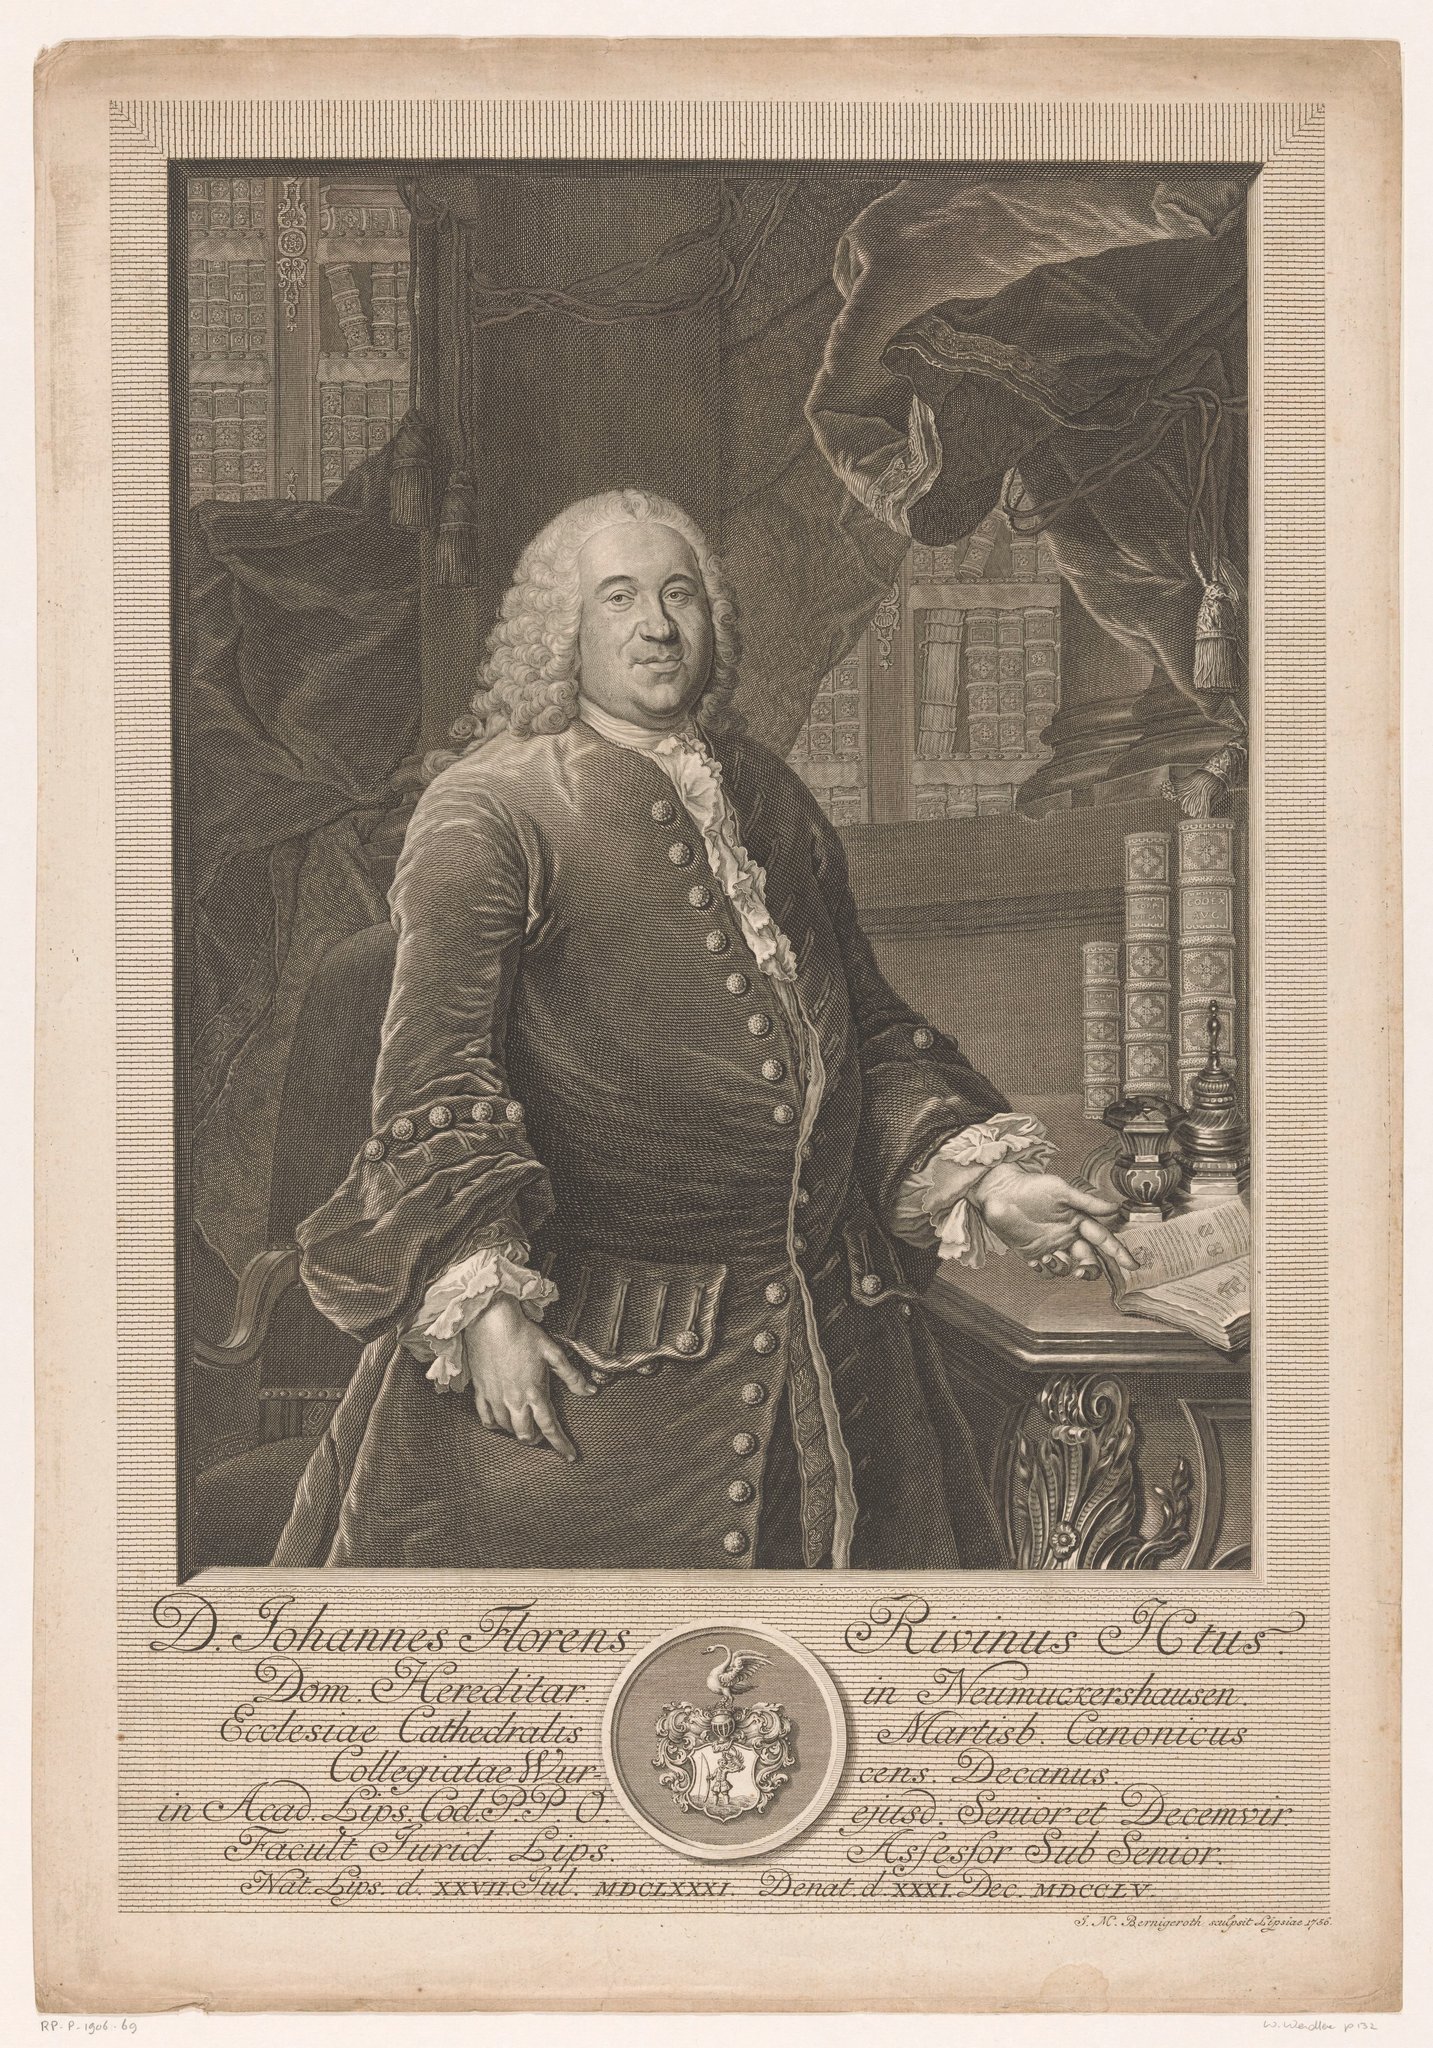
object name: print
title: Portret van Paulus Grundherr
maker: johann friedrich leonard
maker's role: print maker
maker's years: 1633-1680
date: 1643-1680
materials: paper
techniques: engraving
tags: senator, paulus grundherr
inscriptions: collector's mark: Lugt 2228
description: Portret van Paulus Grundherr, senator te Neurenberg.